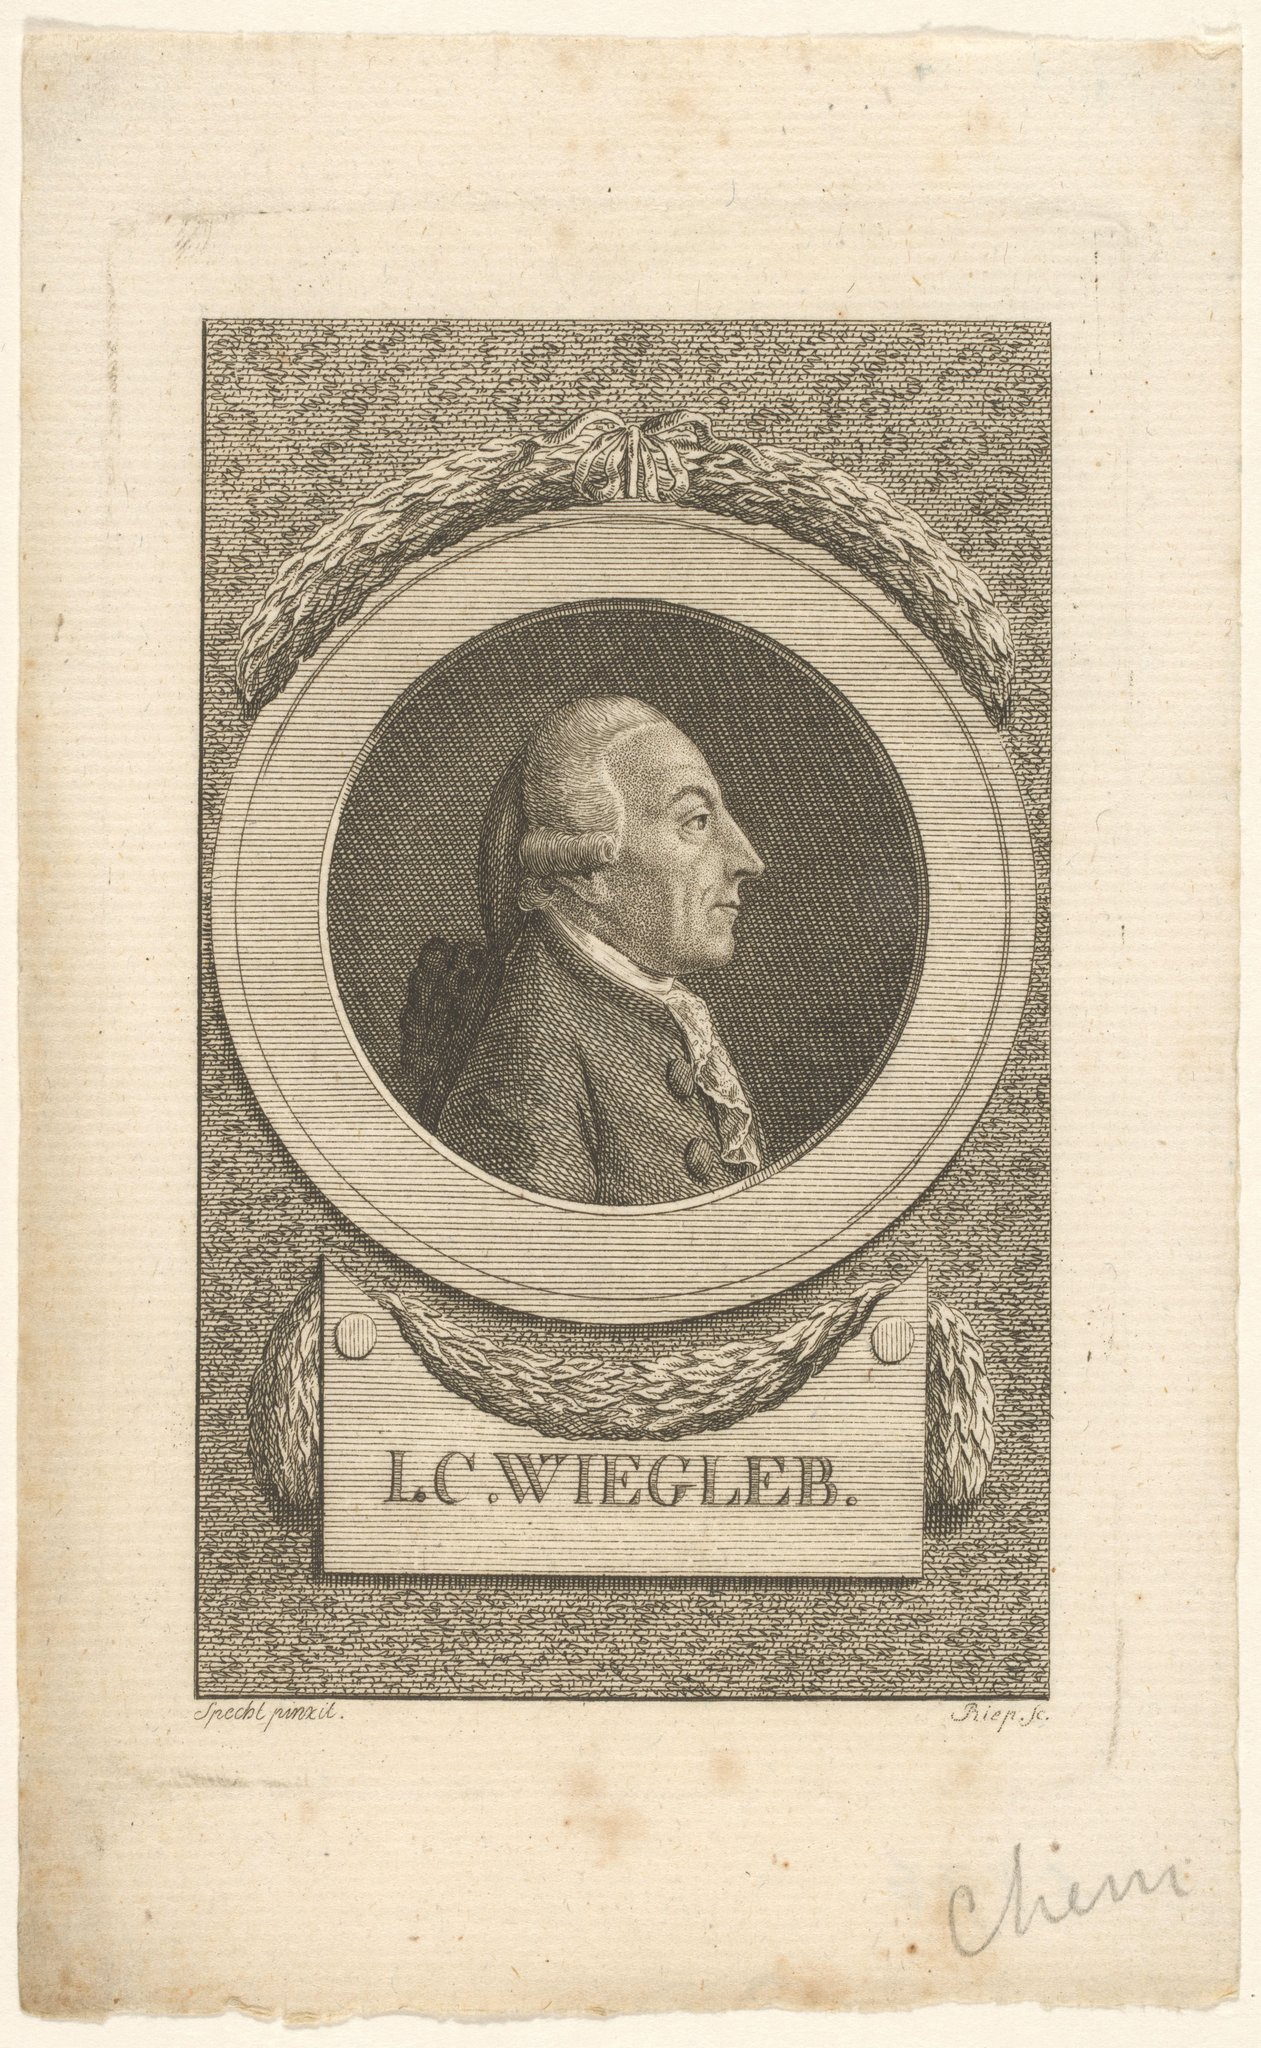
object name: print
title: Portret van Johann Christian Wiegleb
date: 1775-1840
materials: paper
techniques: engraving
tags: historical persons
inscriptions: collector's mark: Lugt 2228